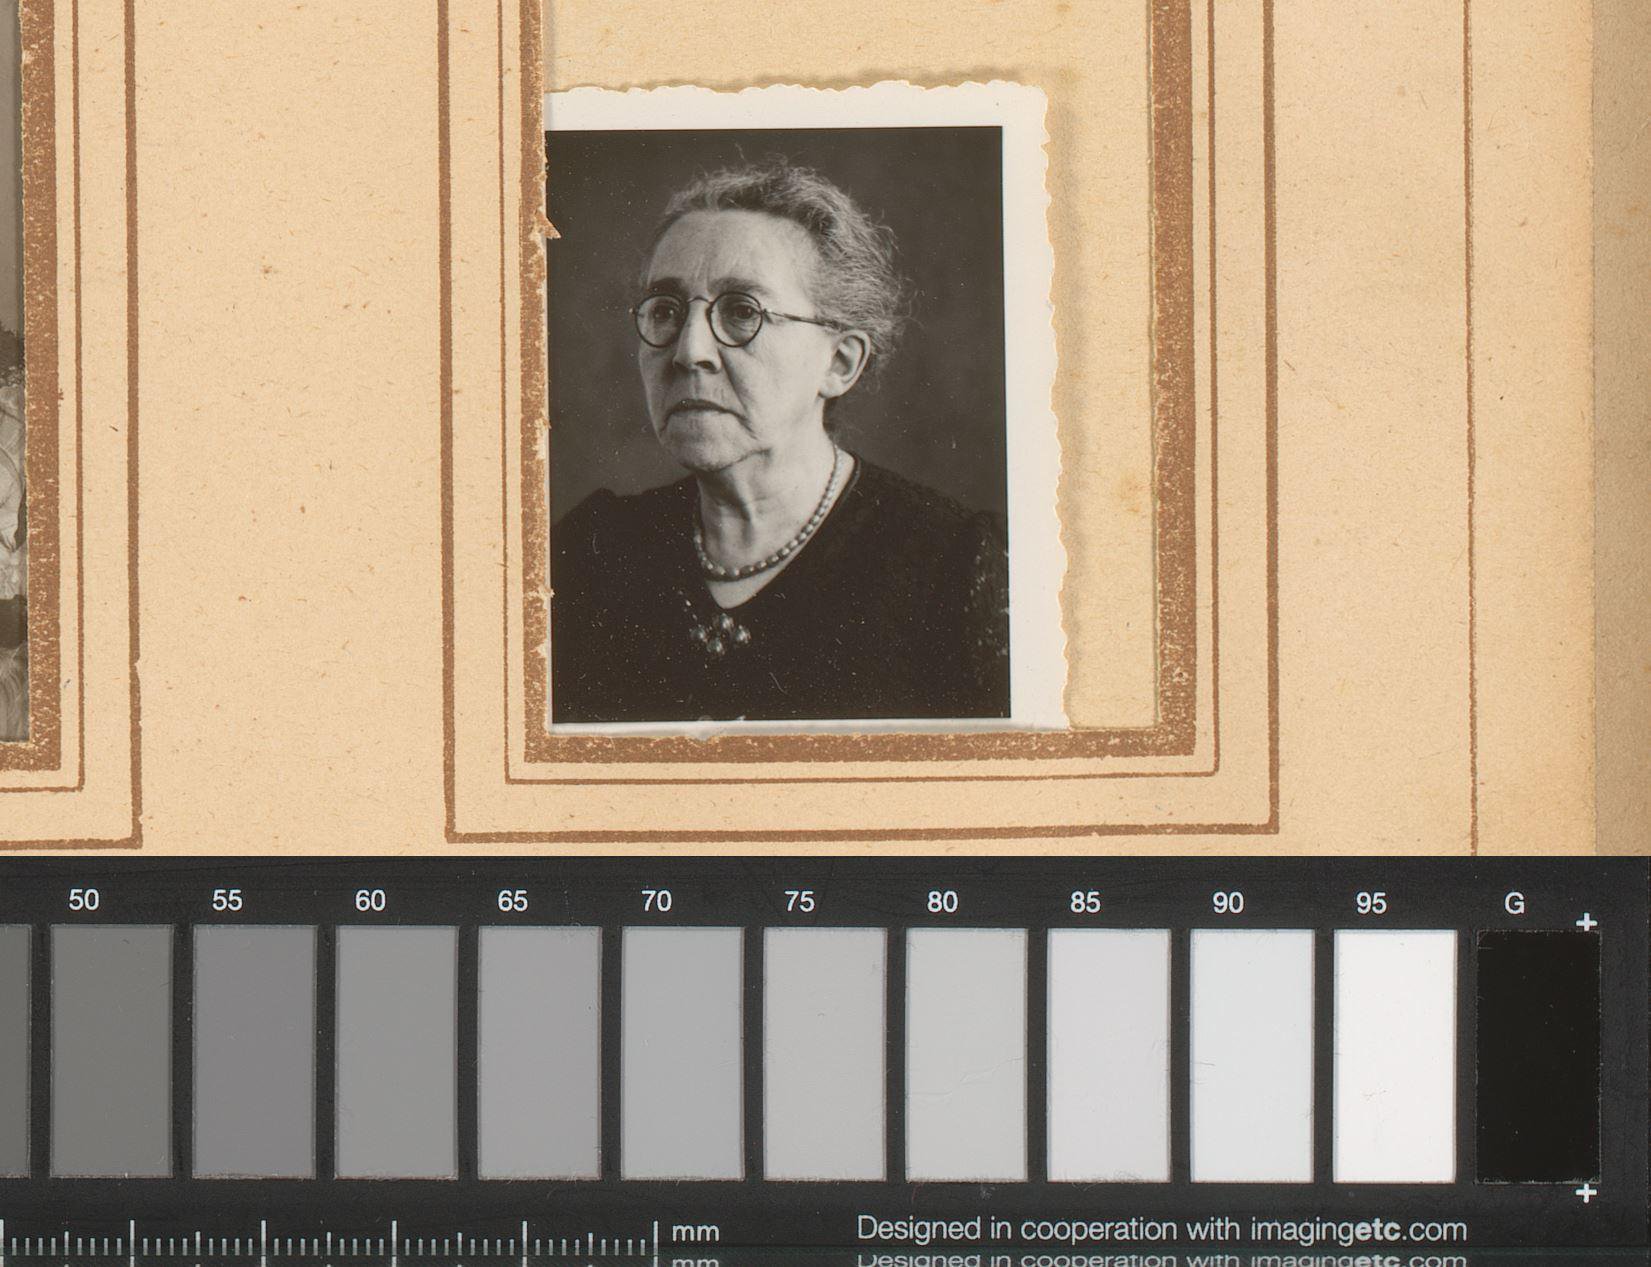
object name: carte de visite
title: Portret van een oude vrouw met bril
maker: Anonymous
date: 1910-1940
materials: photographic support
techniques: gelatin silver print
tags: eyeglasses, spectacles, old woman